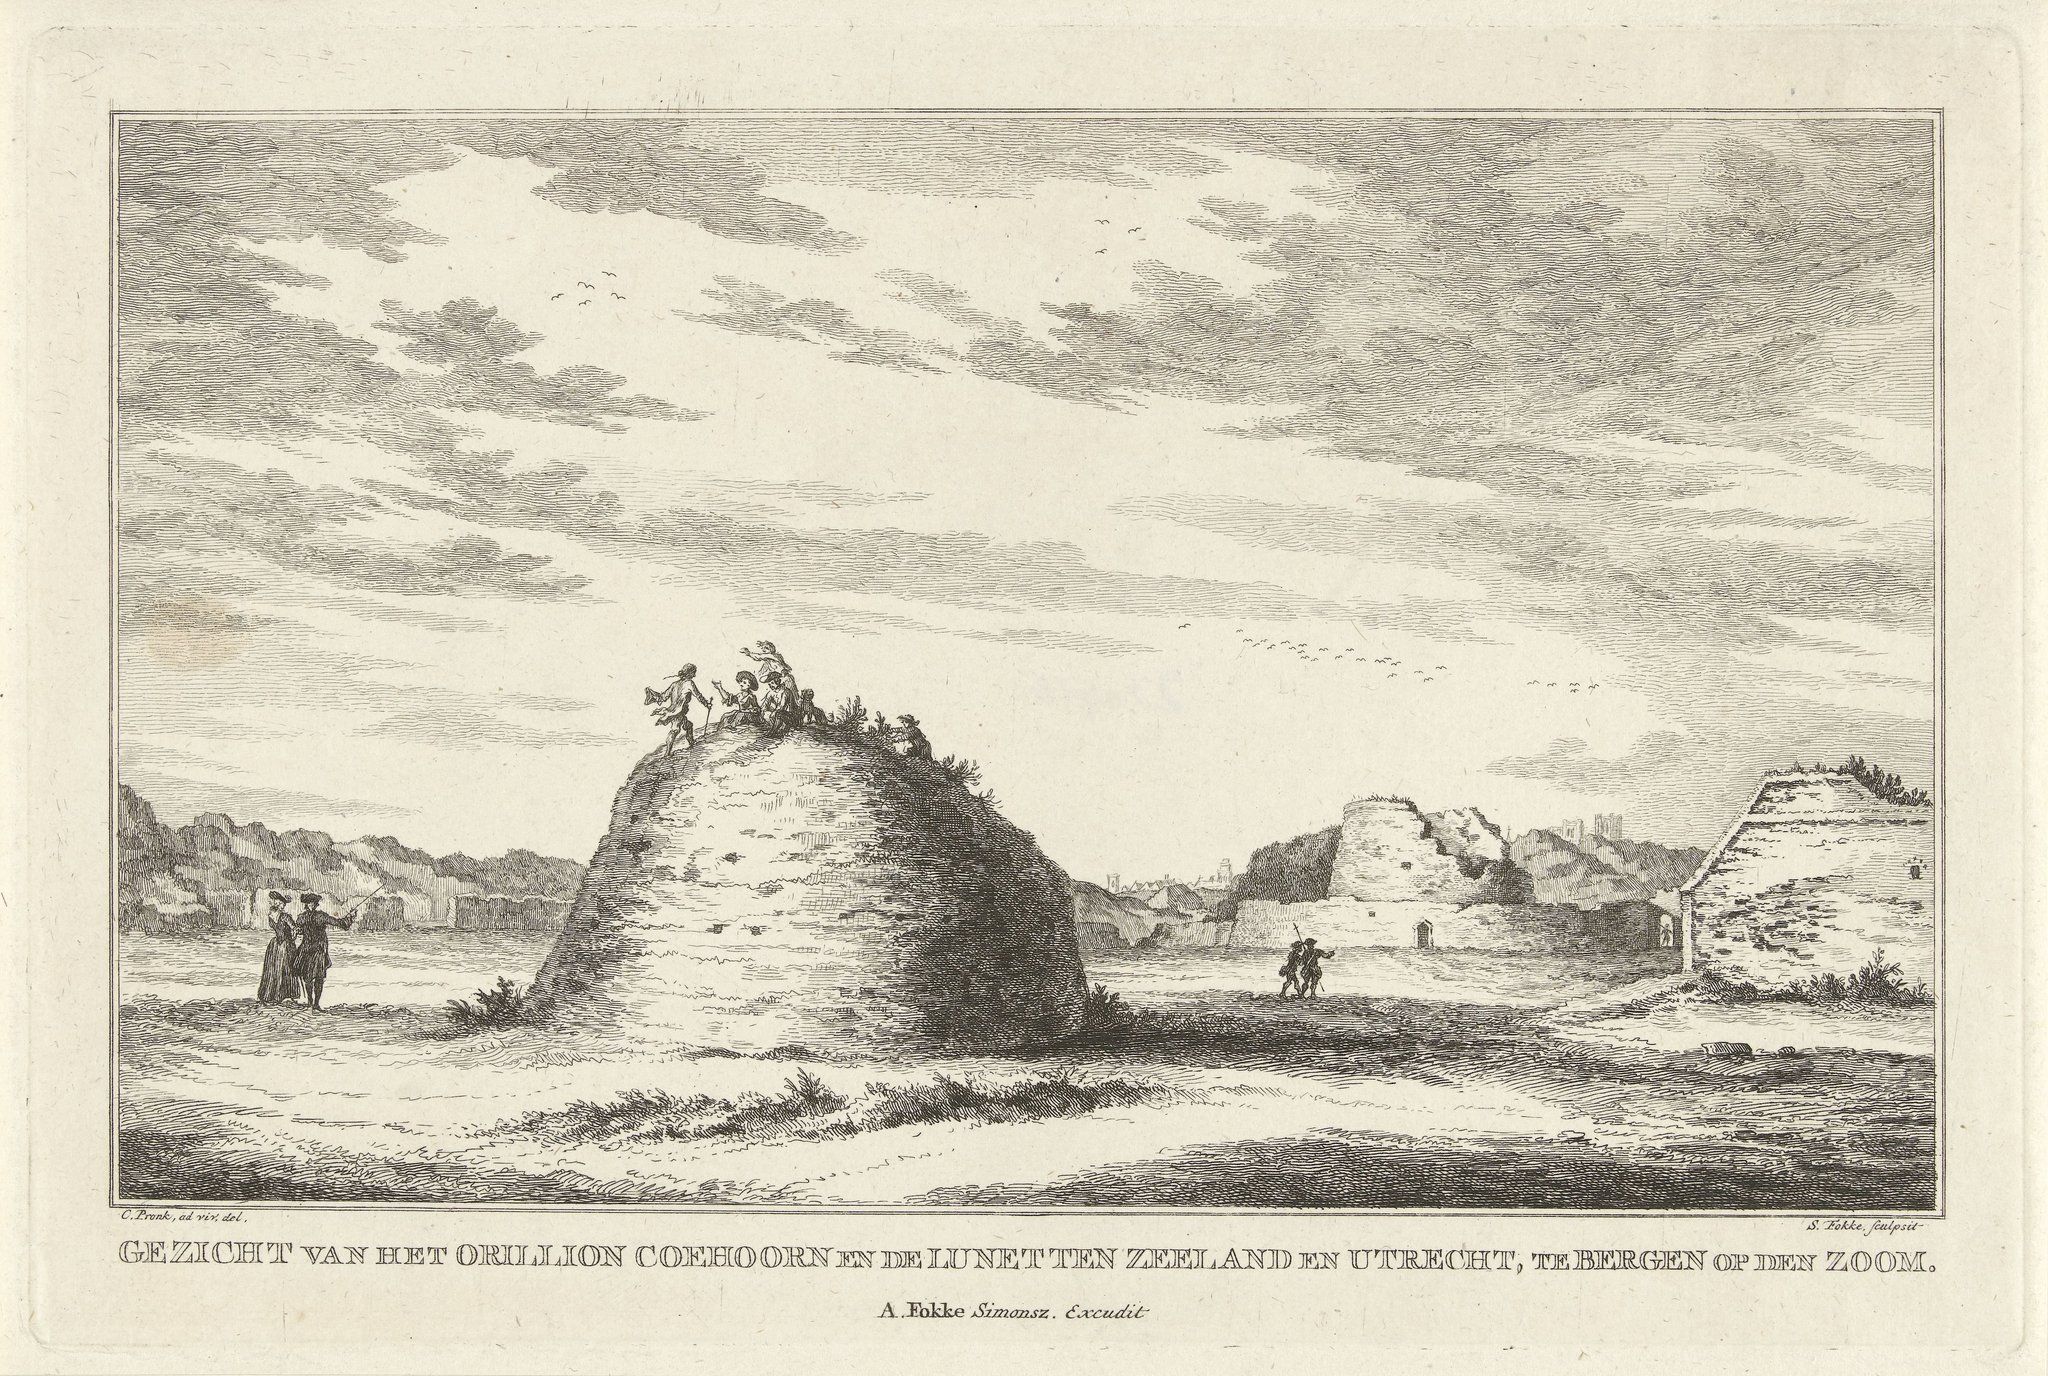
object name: print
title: Gezicht van het Orillion Coehoorn en de Lunetten Zeeland en Utrecht, te Bergen op den Zoom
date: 1774-1784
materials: paper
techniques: etching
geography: amsterdam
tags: fortress, bergen op zoom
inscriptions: collector's mark: Lugt 2233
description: Gezicht op de vestingwerken Coehoorn, Zeeland en Utrecht in Bergen op Zoom. Enkele figuren zijn bovenop een restant van de vesting geklommen. Links en rechts lopen figuren.